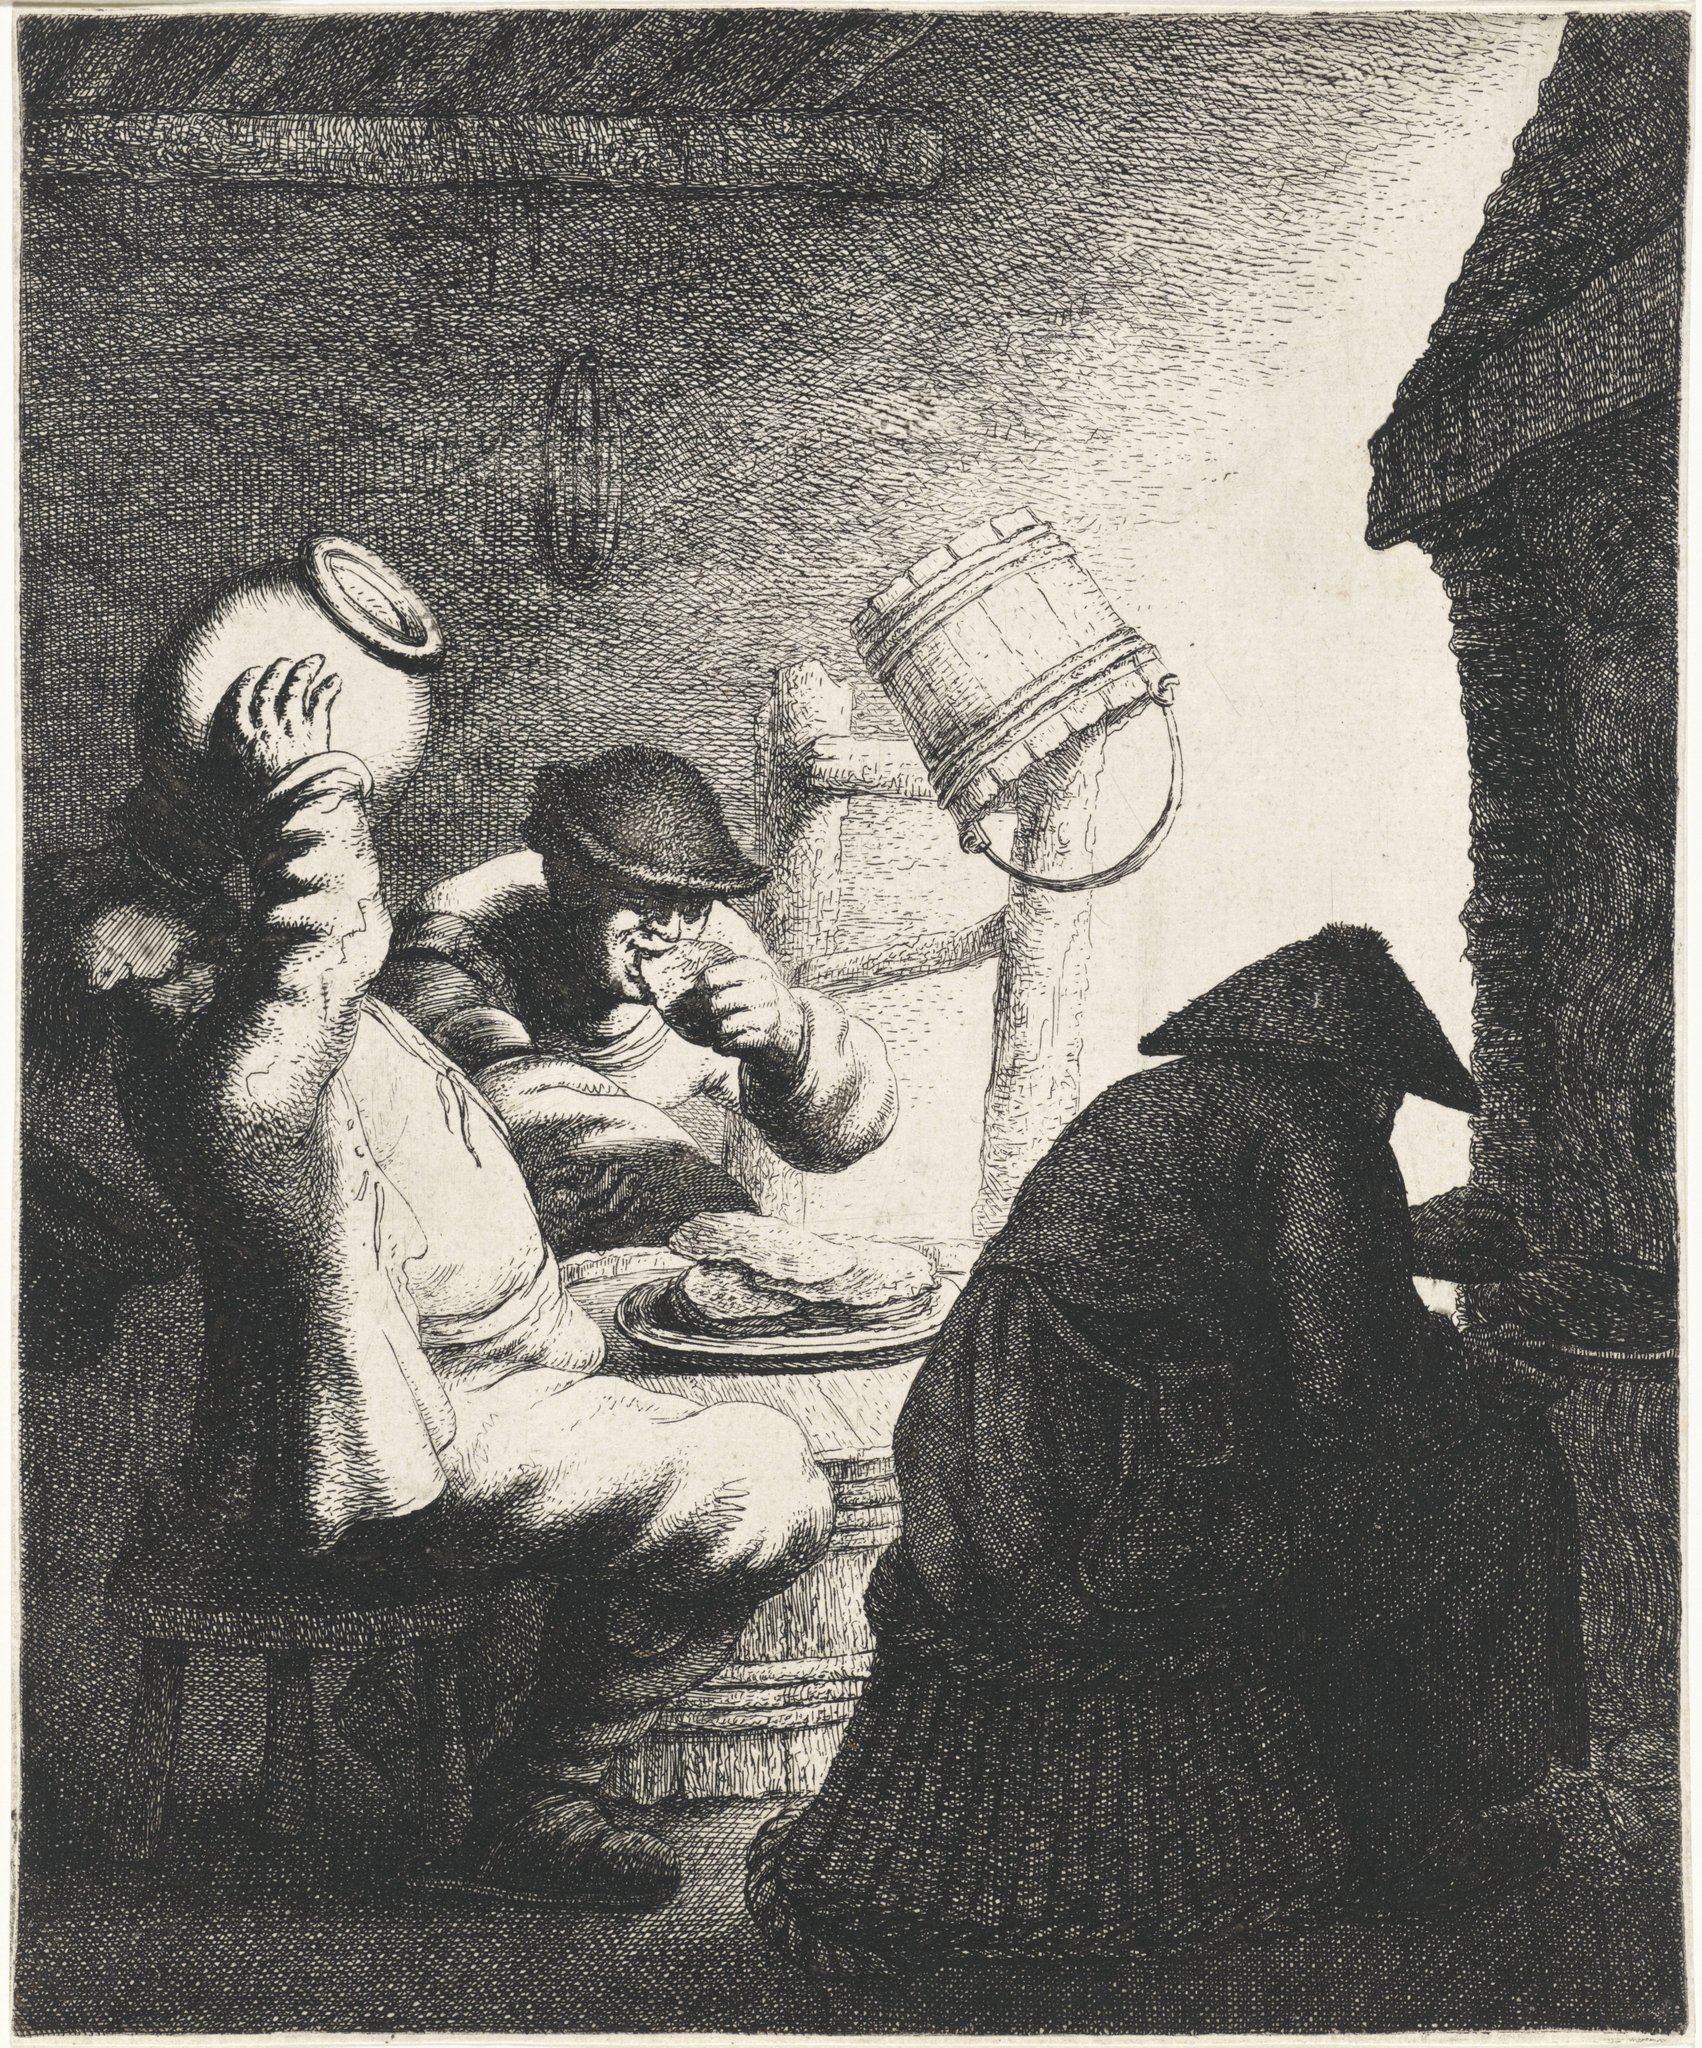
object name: print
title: De vijf zintuigen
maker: jan gillisz. van vliet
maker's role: draughtsman, painter, print maker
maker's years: 1600-1668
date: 1634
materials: paper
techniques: engraving, etching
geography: leiden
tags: pancakes, wooden container: barrel, cask, bucket, taste, tasting (one of the five senses), jar, jug (used as drinking-vessel)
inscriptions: collector's mark: Lugt 240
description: In een boereninterieur bakt een vrouw pannenkoeken op een vuur. Aan een ronde tafel zit een man die pannenkoeken eet en een man die uit een kruik drinkt. Op een hek een omgekeerde emmer.